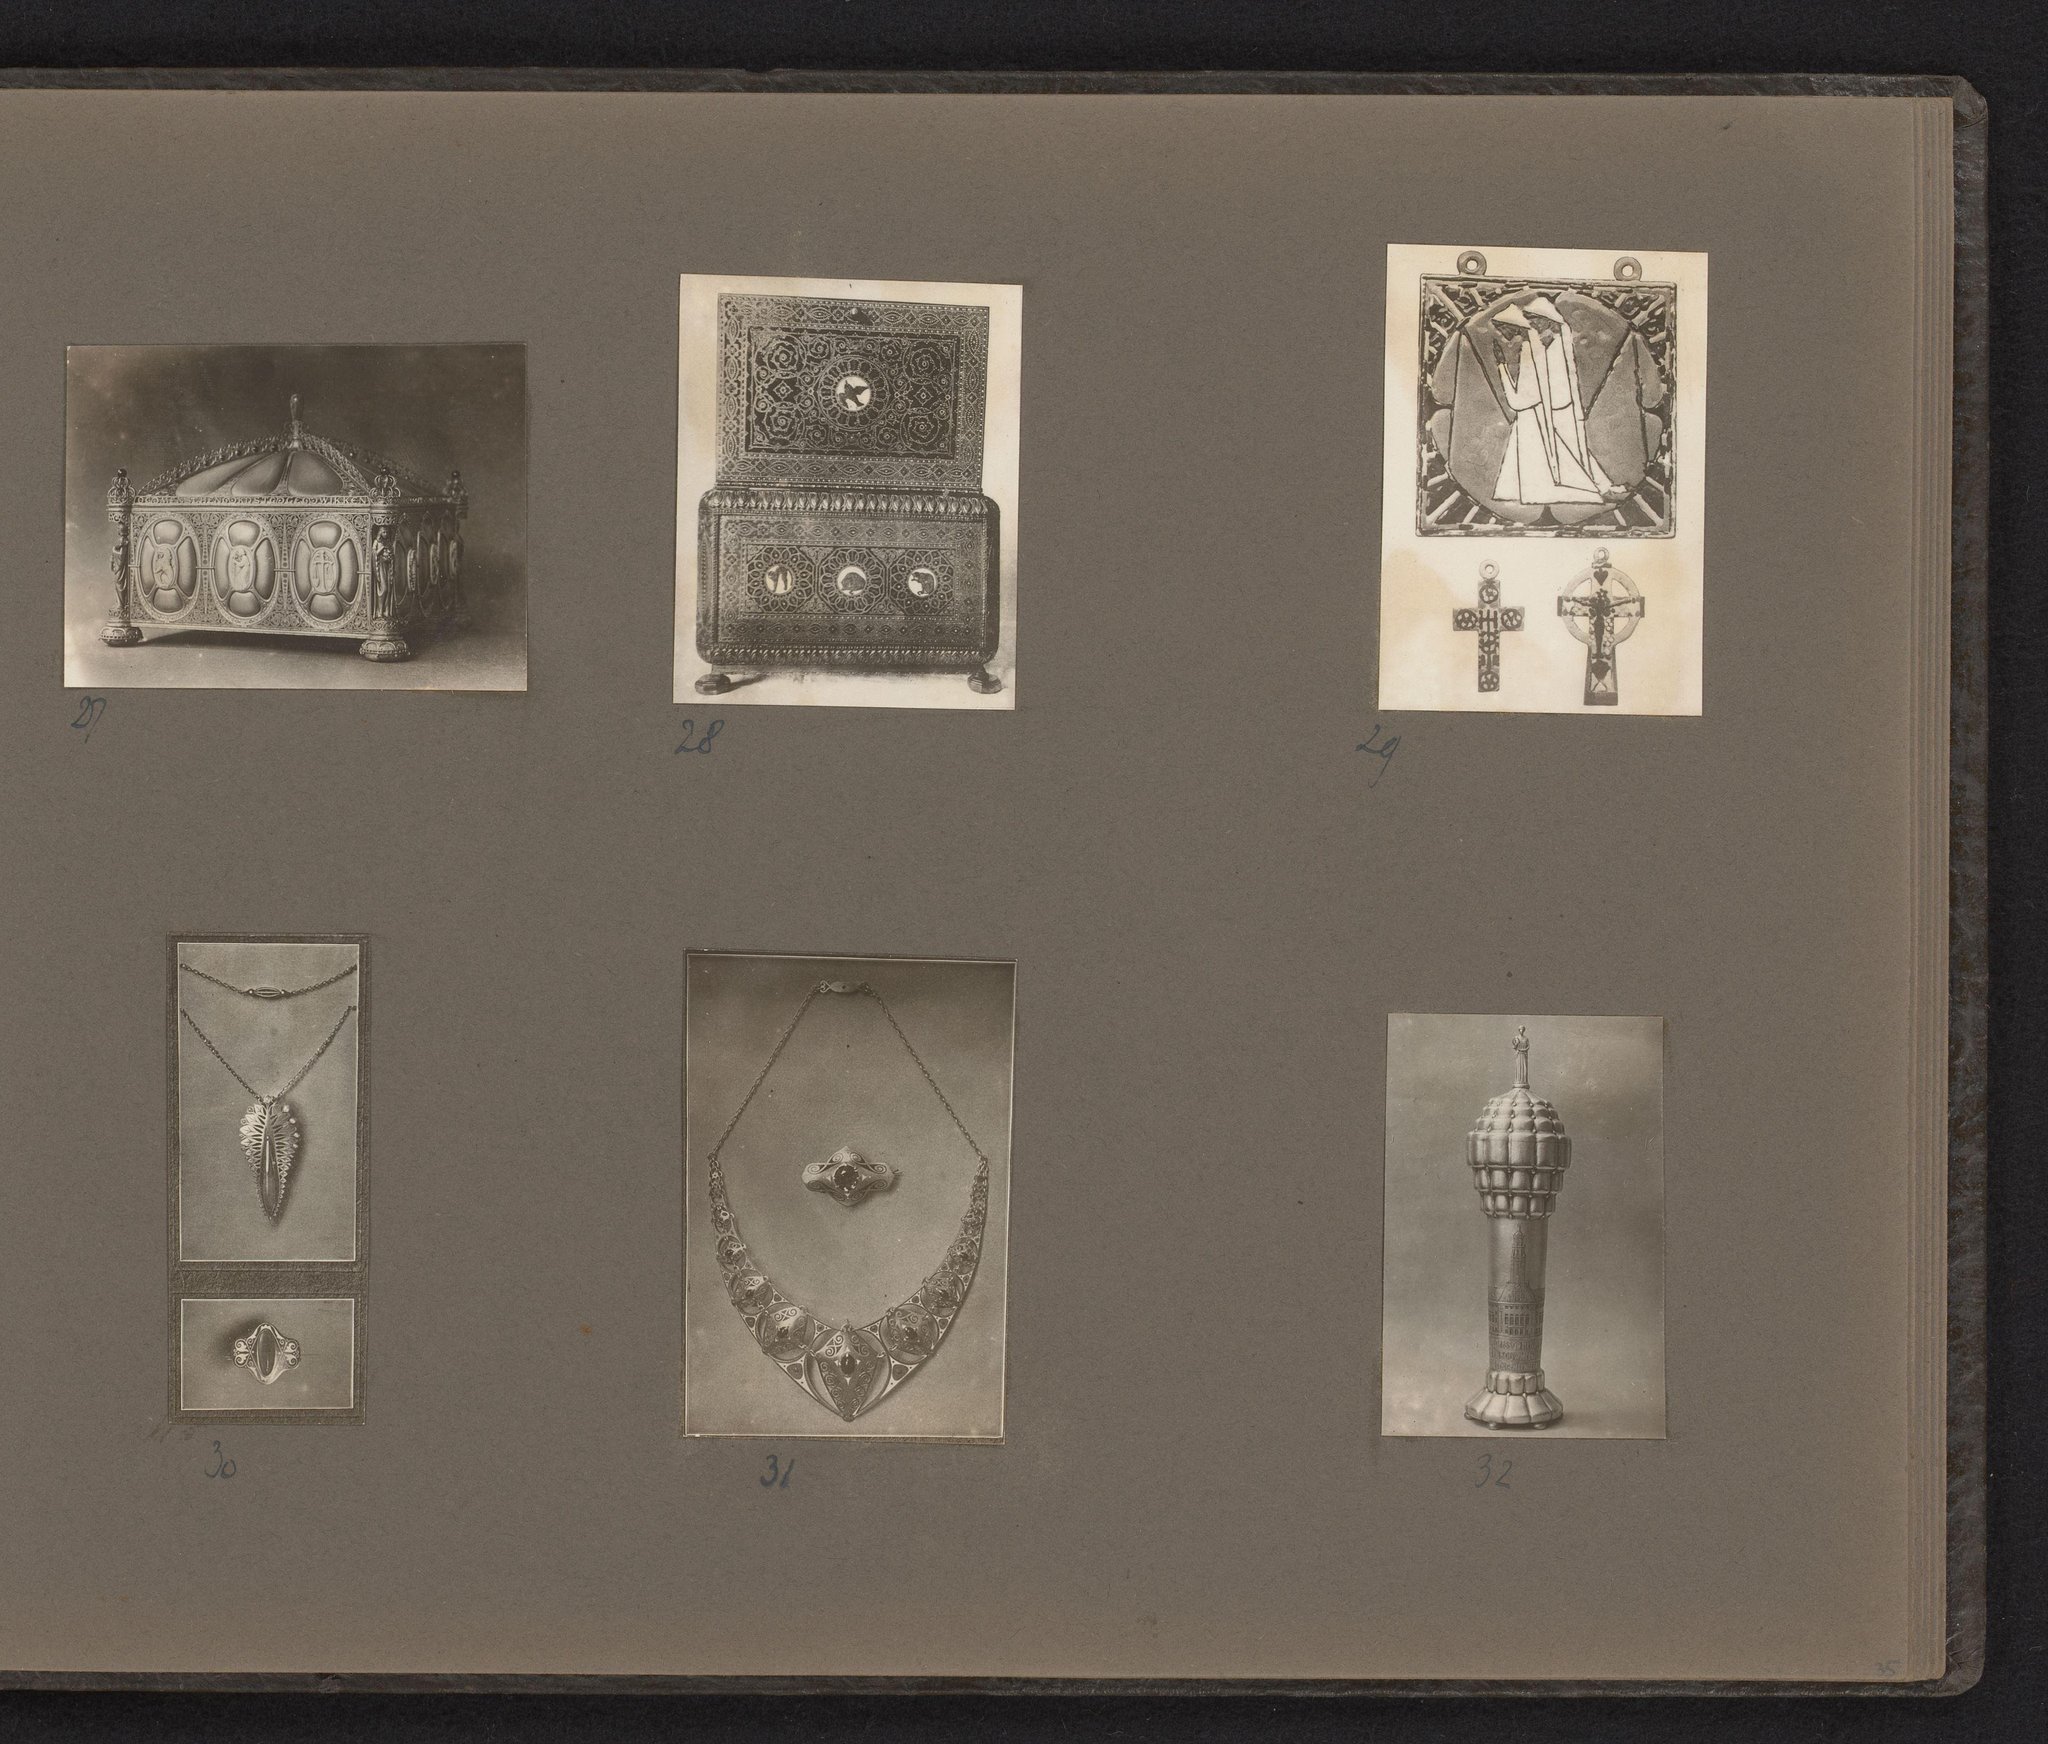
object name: album leaf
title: Sieraden en een decoratief object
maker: Anonymous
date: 1920-1940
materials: paper, photographic support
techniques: gelatin silver print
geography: netherlands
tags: ring, jewel-box, necklace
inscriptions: number: ‘27 - 28 - 29/ 30 - 31 - 32’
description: Afgebeeld zijn twee sieradendozen, drie religieuze hangers, twee sets van een ketting en een ring en een decoratief object. Deze foto's maken deel uit van een album.